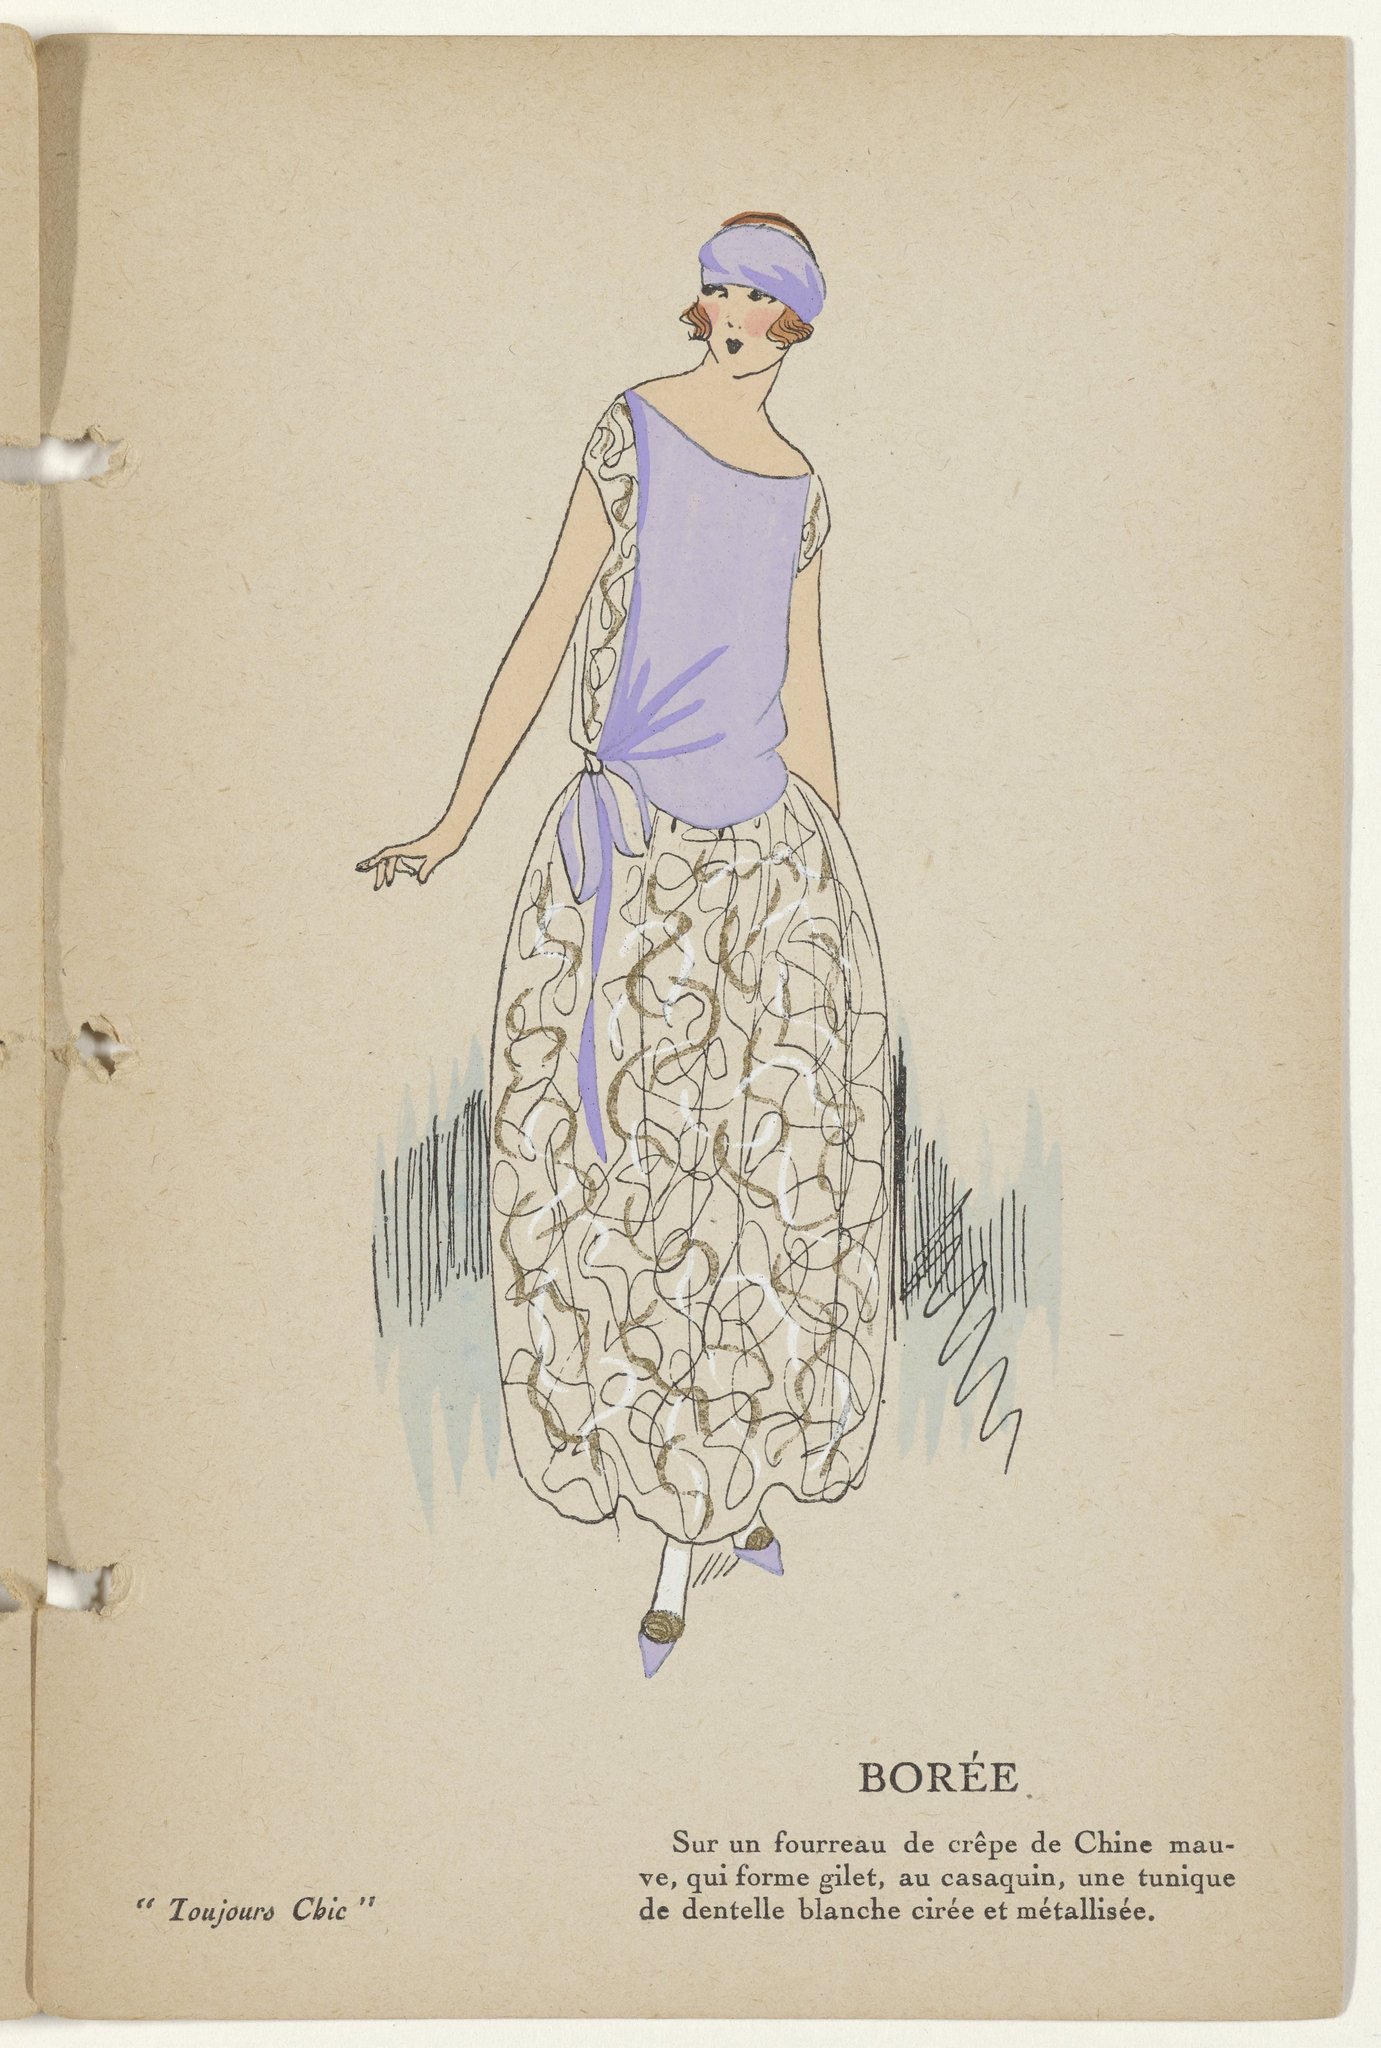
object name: fashion print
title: Toujours Chic Les Deshabillés, Hiver 1921-1922: Borée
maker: g-p. joumard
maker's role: publisher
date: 1921-1922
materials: paper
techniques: letterpress printing, pochoir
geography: paris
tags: fashion plates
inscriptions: date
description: Prent uit Catalogus "Toujours Chic" waarin een overzicht van de wintermode 1921-1922.